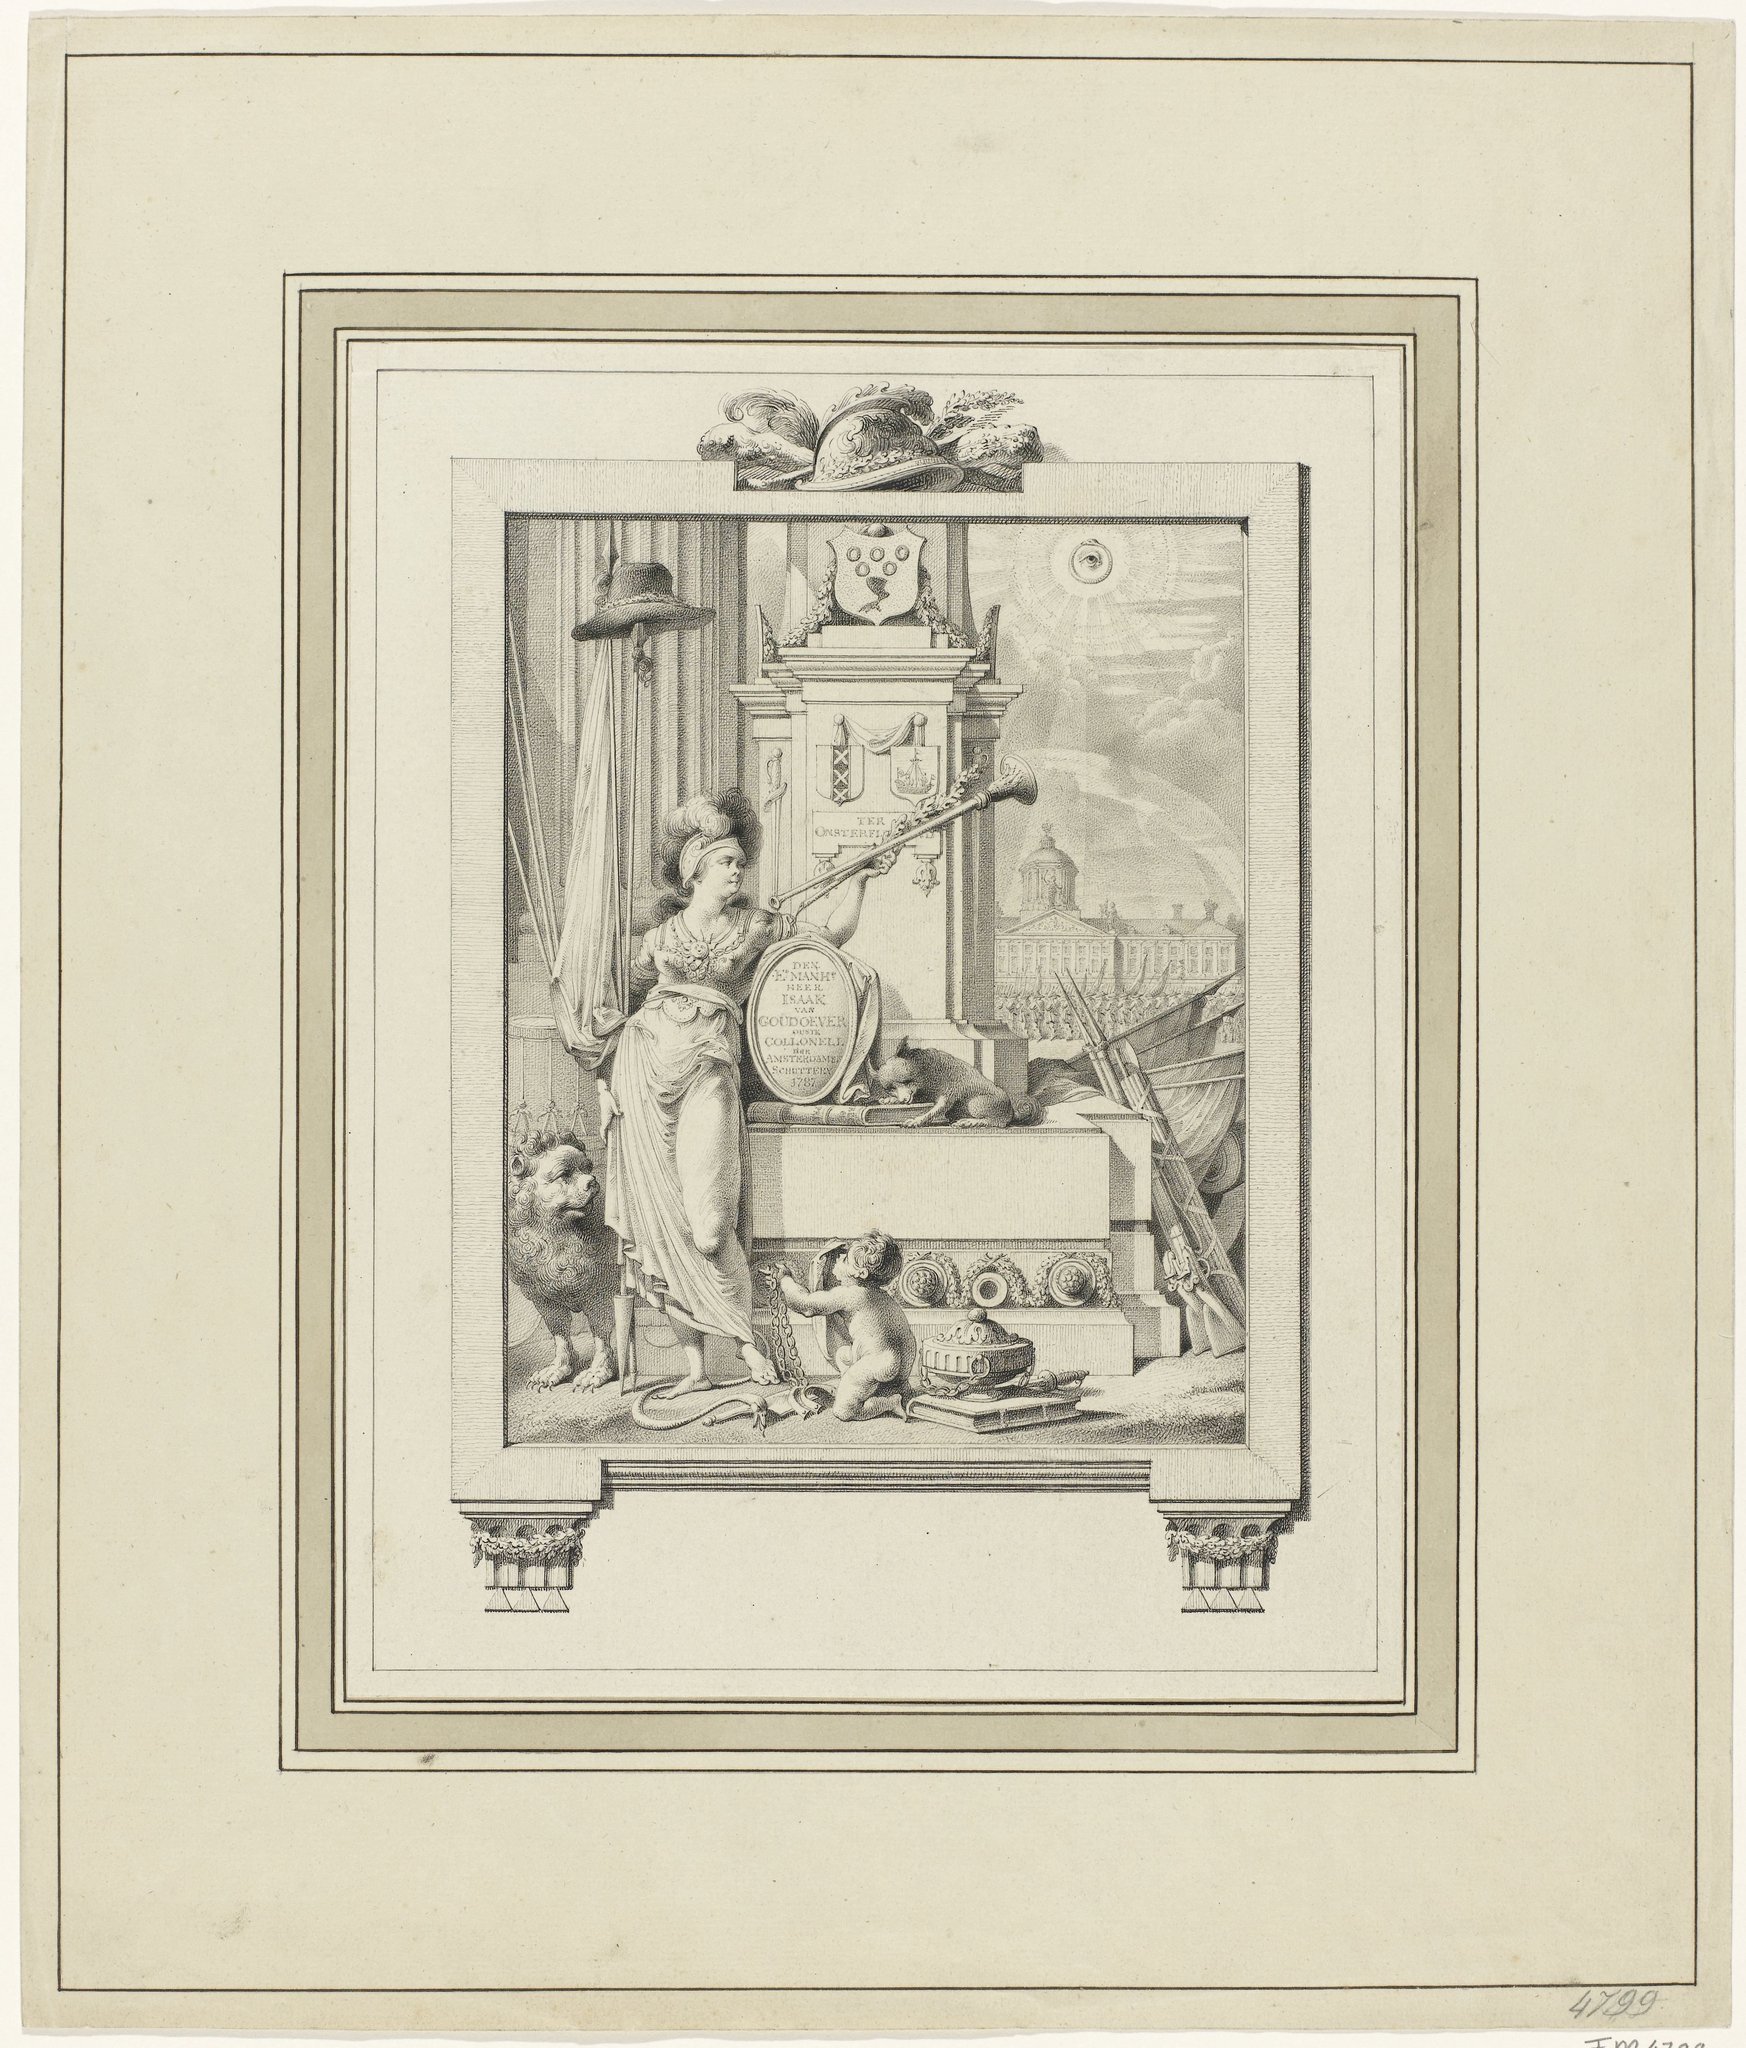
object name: drawing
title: Allegorisch monument voor Isaak van Goudoever, 1787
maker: johannes van dregt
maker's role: draughtsman, painter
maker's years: 1737-1807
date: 1787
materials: paper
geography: northern netherlands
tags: amsterdam, the all-seeing eye, triangle with eye ~ symbol of god the father, fame; 'fama', 'fama buona', 'fama chiara' (ripa), freedom, liberty; 'libertà' (ripa) (+ abstract concept represented by female figure), patriots (1780-1795)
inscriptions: collector's mark: Lugt 2228, inscription: ‘Deese van grondts af aan geteekendt met de ordinaer schreijfpen. Naar de origineele Teekening met oostindize inkt gewassen. Beyden door den Schilder Johannes van Drecht.’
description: Monument voor Isaak van Goudoever, de oudste kolonel van de schutterij in Amsterdam, 1787. De Vrijheid of Faam staande met speer met vrijheidshoed en bazuin voor een zuil met de wapens van Goudoever en Amsterdam. Links de Nederlandse leeuw. Op de achtergrond het Amsterdamse Stadhuis en een marcherende vrijkorps. In de lucht het Alziende Oog.